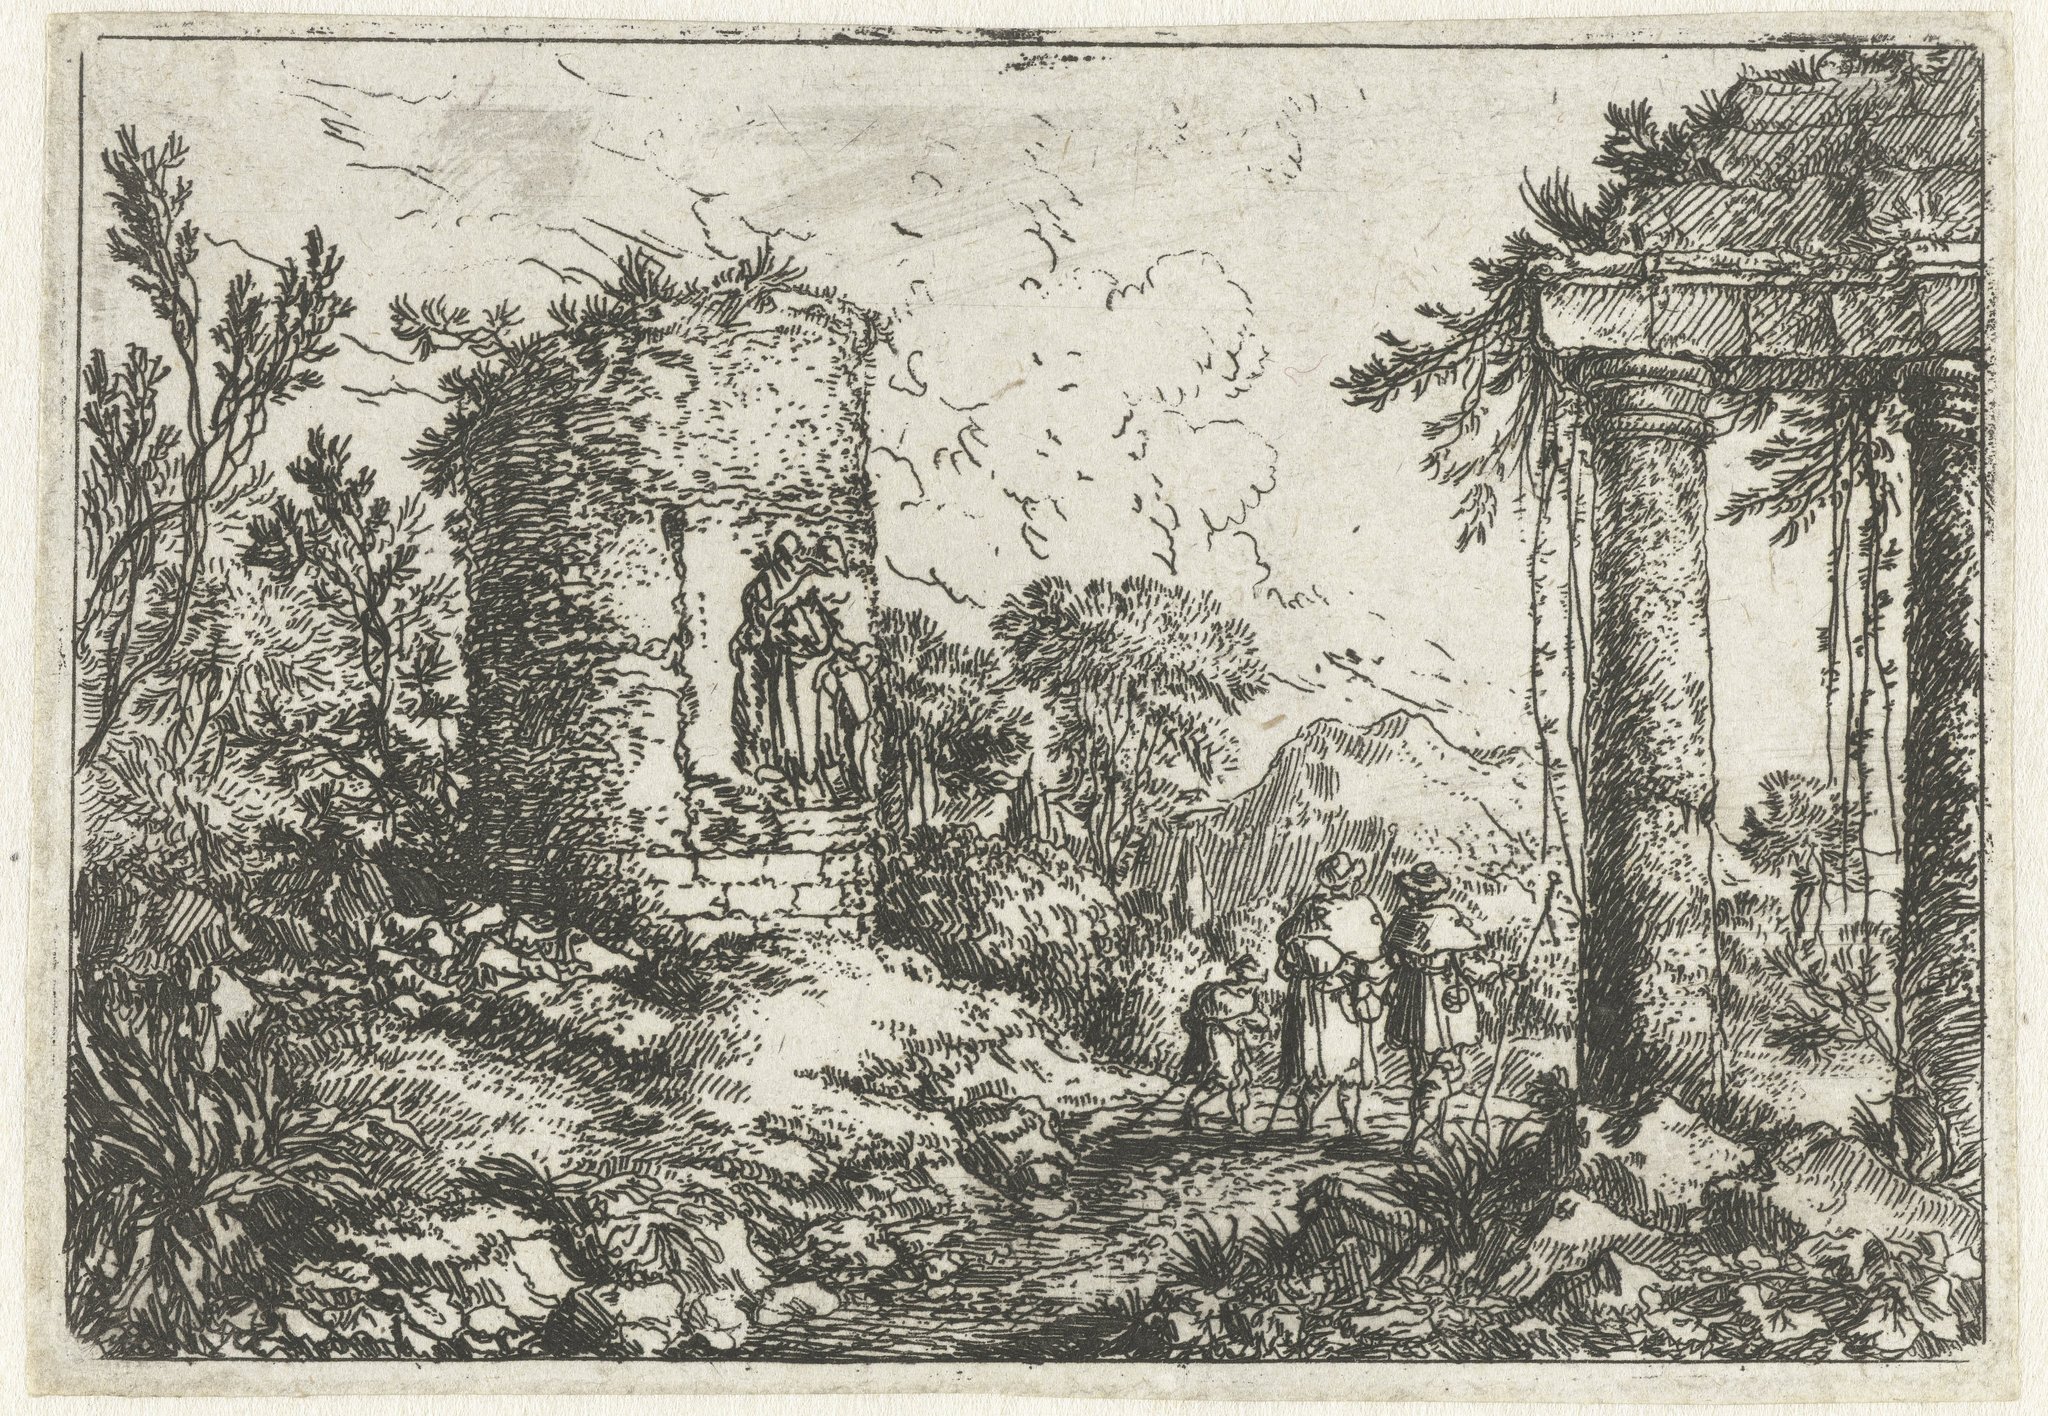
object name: print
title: Landschap met ruïnes en drie pelgrims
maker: jonas umbach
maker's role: print maker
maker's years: 1624-1693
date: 1634-1693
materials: paper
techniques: etching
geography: augsburg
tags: landscape with ruins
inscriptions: collector's mark: Lugt 240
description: Lanschap met links en rechts van een pad een ruïne. Op het pad drie wandelaars.